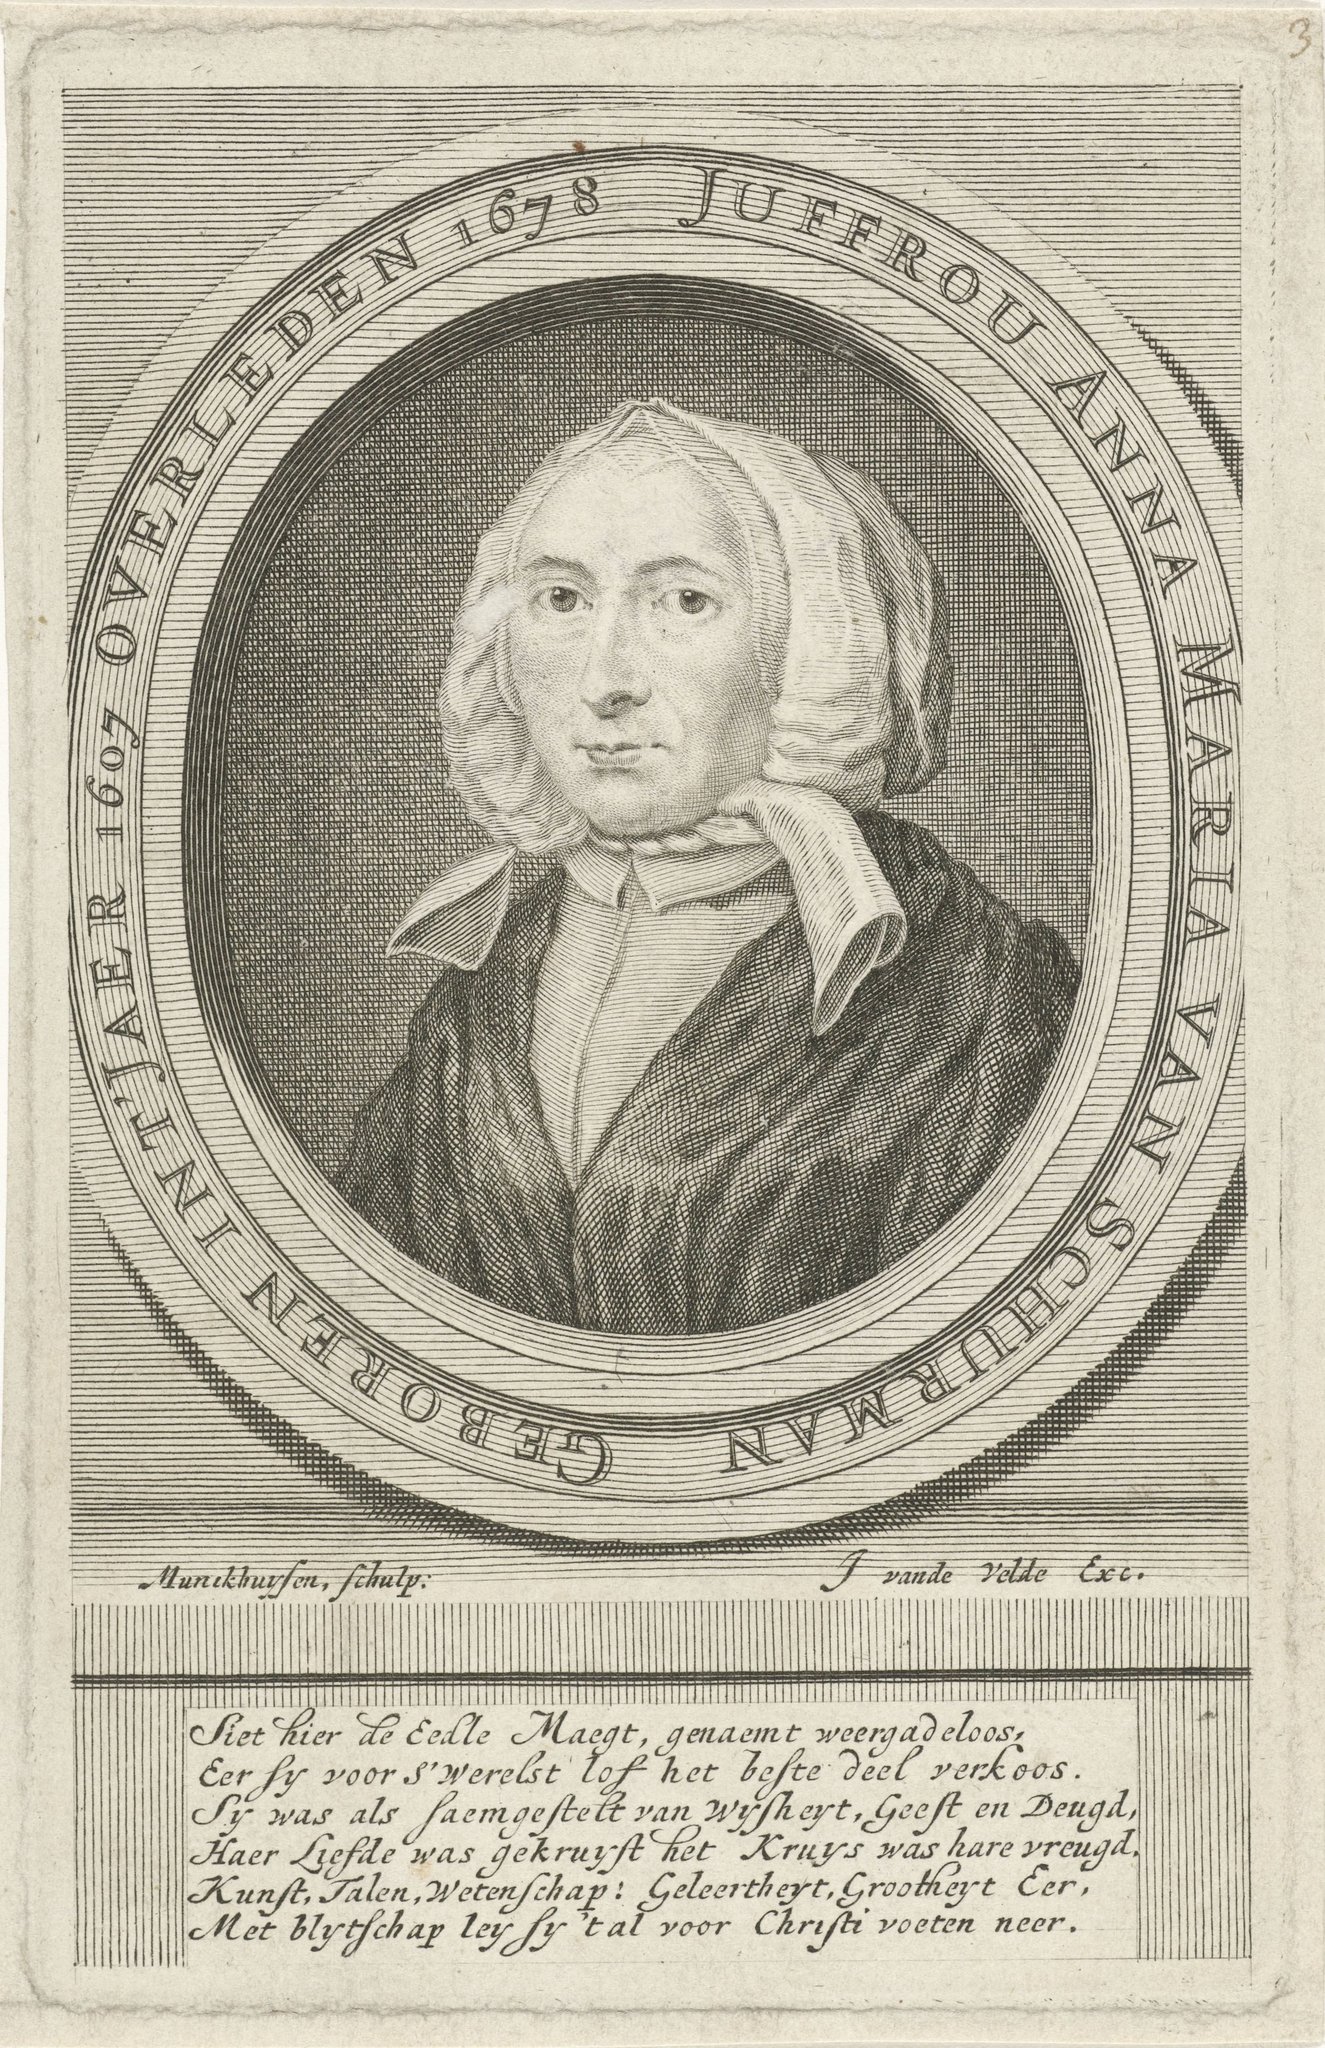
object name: print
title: Portret van Anna Maria van Schurman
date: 1678-1680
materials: paper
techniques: engraving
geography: netherlands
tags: print maker, draughtsman, anna maria van schurman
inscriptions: collector's mark: Lugt 2228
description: Portret van Anna Maria van Schurman, dichteres en prentmaakster. Onder het portret een zesregelig vers in het Nederlands.